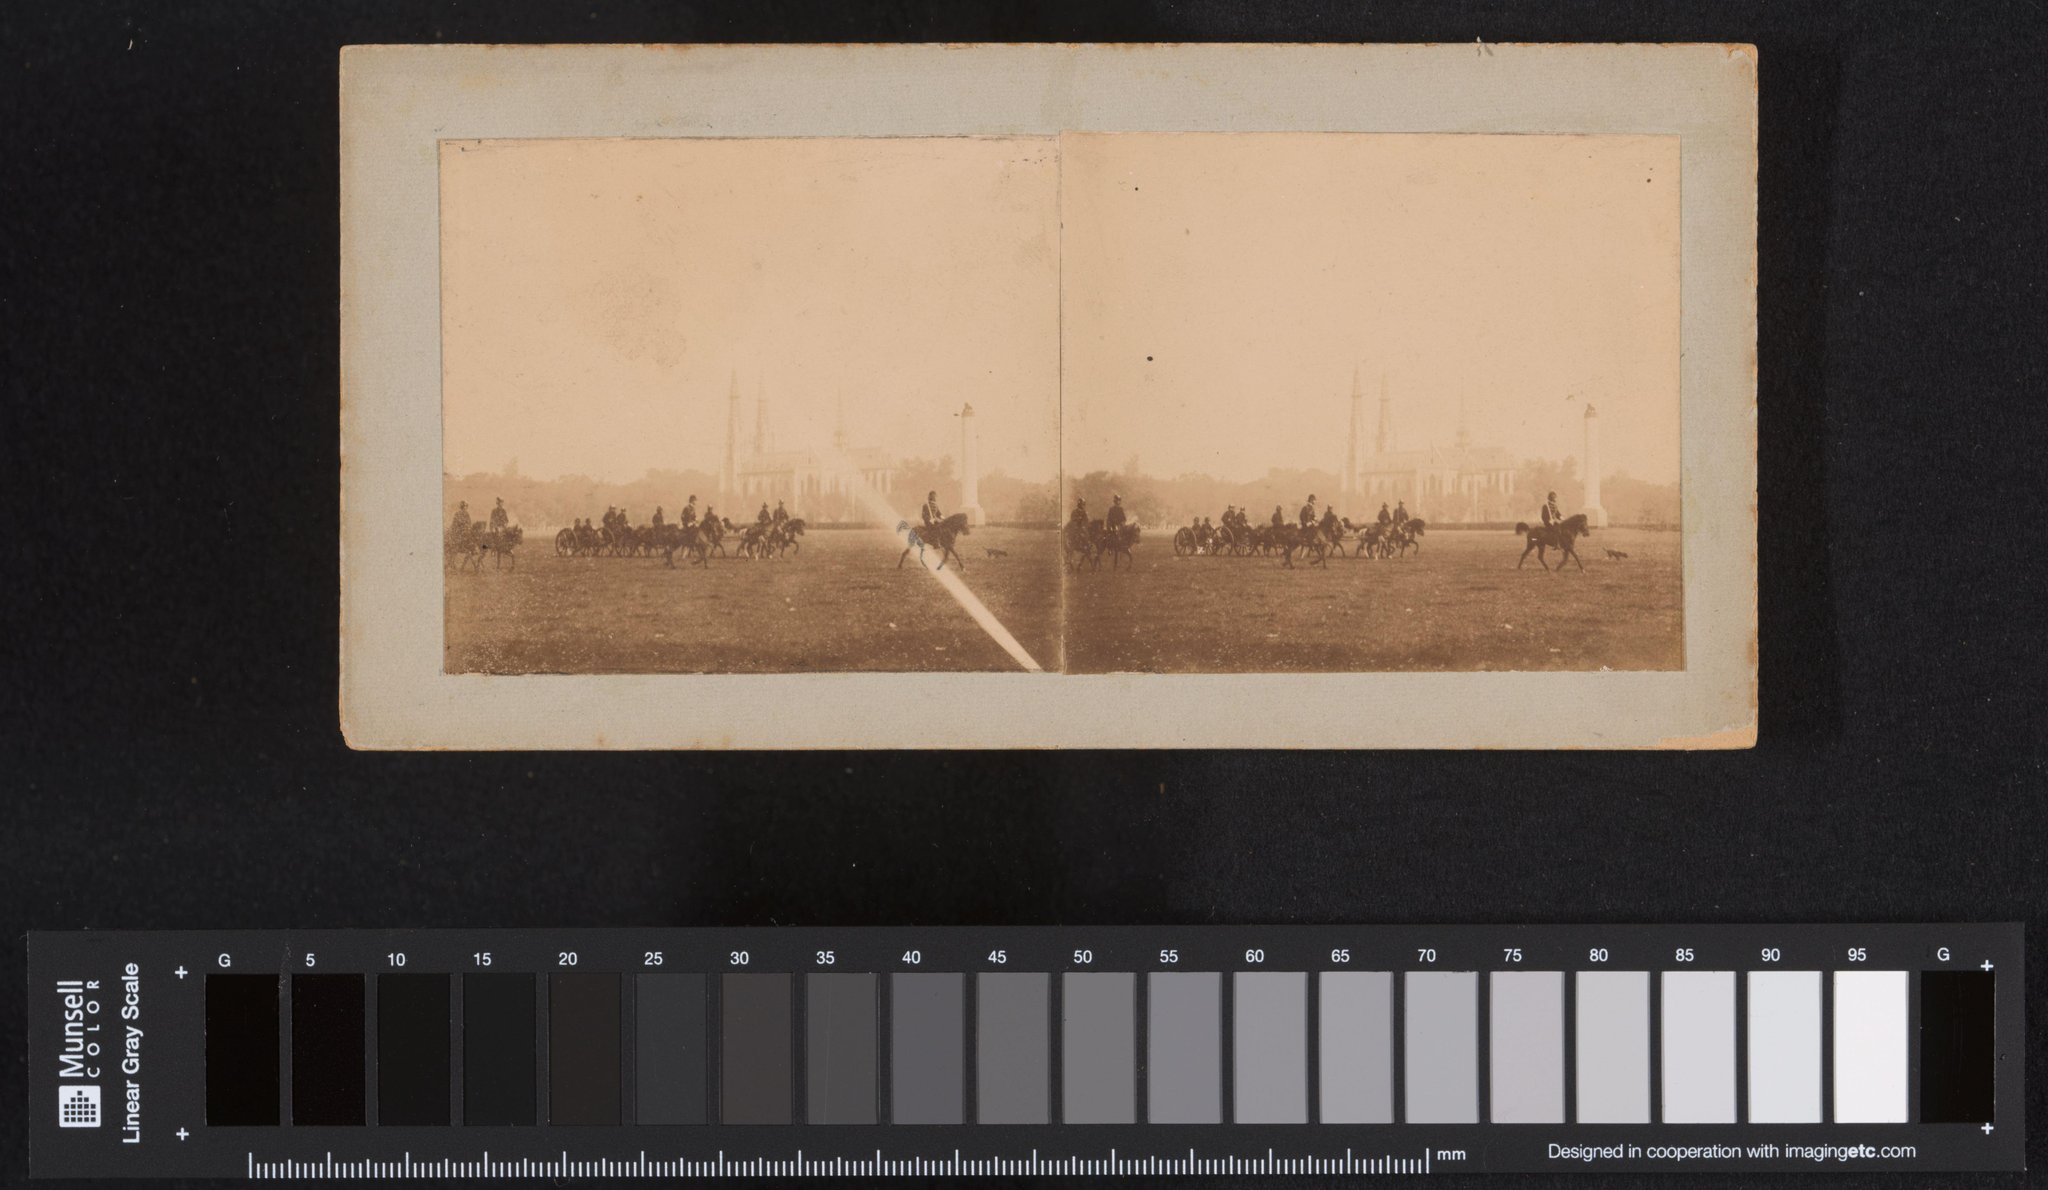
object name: stereograph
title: Militaire oefening op het Waterlooplein te Batavia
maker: robert julius boers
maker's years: 1867-1932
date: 1903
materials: cardboard, photographic support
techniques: gelatin silver print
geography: batavia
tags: robert julius boers, batavia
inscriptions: inscription: ‘Waterlooplein met gezicht op de Roomsche Kerk gedurende parade’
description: Militaire oefening op het Waterlooplein te Batavia, 1903. Op de achtergrond de rooms-katholieke kerk. Onderdeel van een groep stereofoto's van Robert Julius Boers, chef van het staatsbedrijf de Banka-tinwinning op Banka, uit de periode ca. 1900-1922.